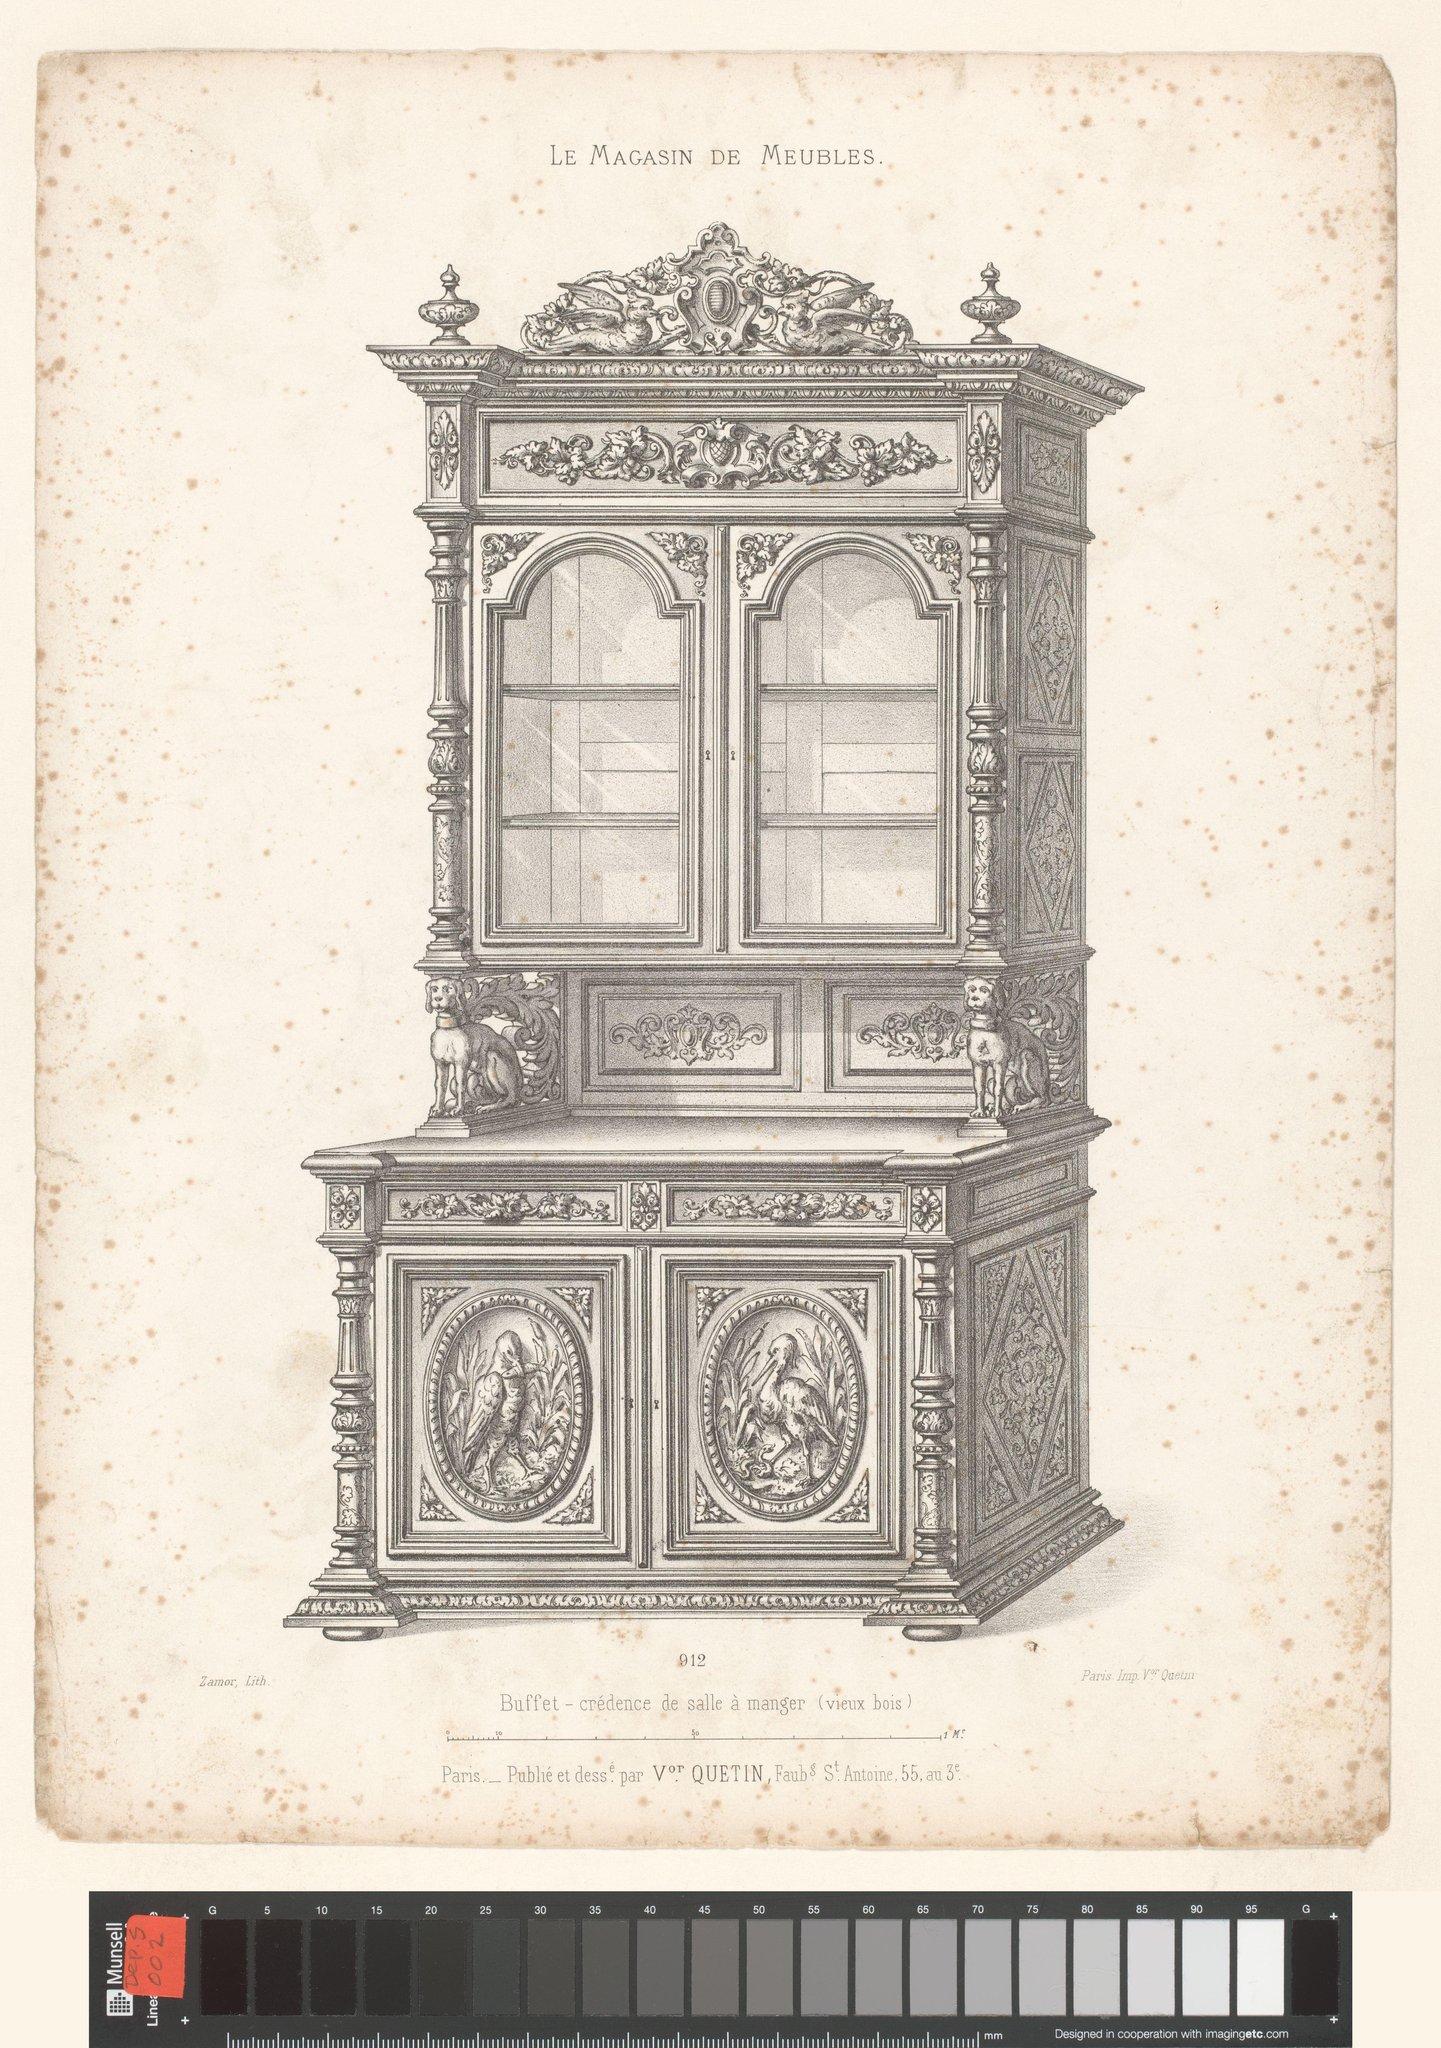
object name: print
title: Twee vensters met gordijnen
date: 1885-1895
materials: paper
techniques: hand coloring, lithograph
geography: paris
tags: window, hangings and drapery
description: Twee vensters met gedrapeerde gordijnen. Prent uit 289e Livraison.